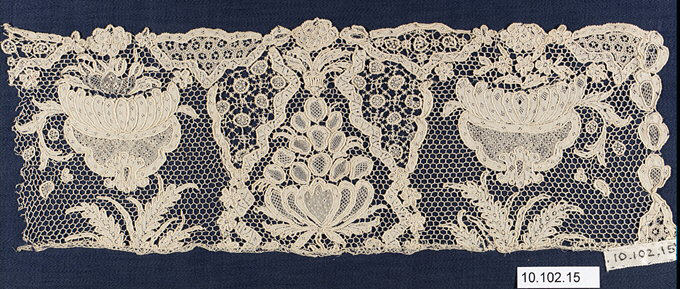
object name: fragment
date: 1701-1800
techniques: lace